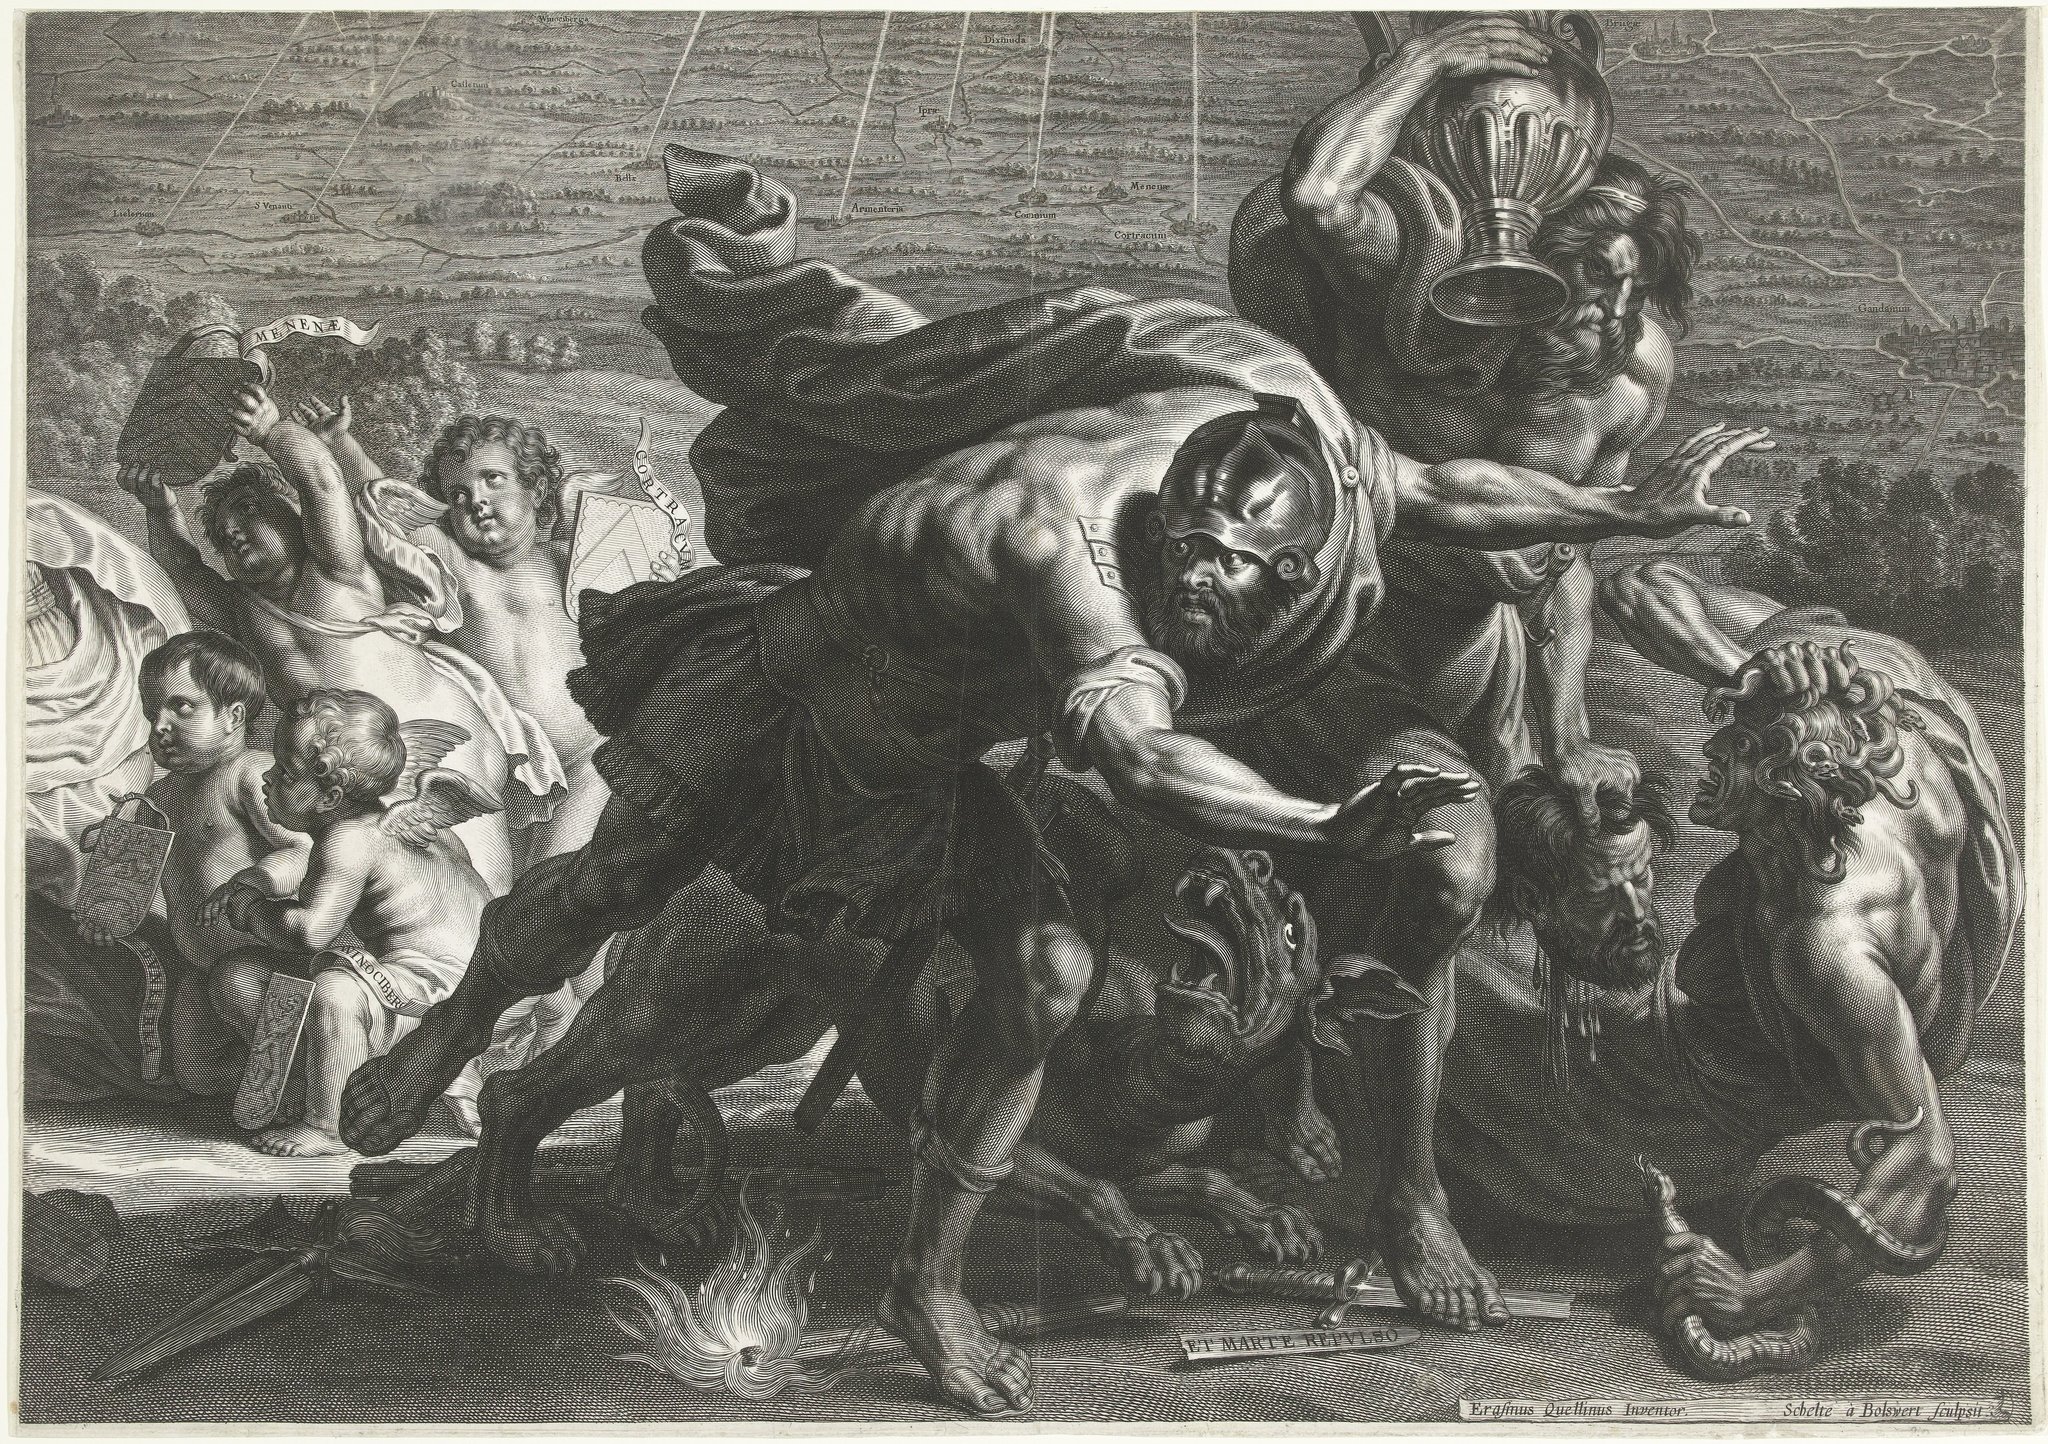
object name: print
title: Intocht van Leopold Willem, landvoogd der Zuidelijke Nederlanden, te Gent (rechtsonder)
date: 1653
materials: paper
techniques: engraving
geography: antwerp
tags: vienna, leopold willem van oostenrijk (landvoogd der zuidelijke nederlanden), equestrian state-portrait, conqueror triumphing, triumphal entry of victor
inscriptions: collector's mark: Lugt 240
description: Intocht van Leopold Willem, landvoogd der Zuidelijke Nederlanden, te Gent. Prent bestaande uit vier delen. Dit is het deel rechtsonder. Na de intocht van Leopold Willem vluchten de vijanden uit Gent. Op de achtergrond een kaart van de Zuidelijke Nederlanden met rechts de stad Gent.